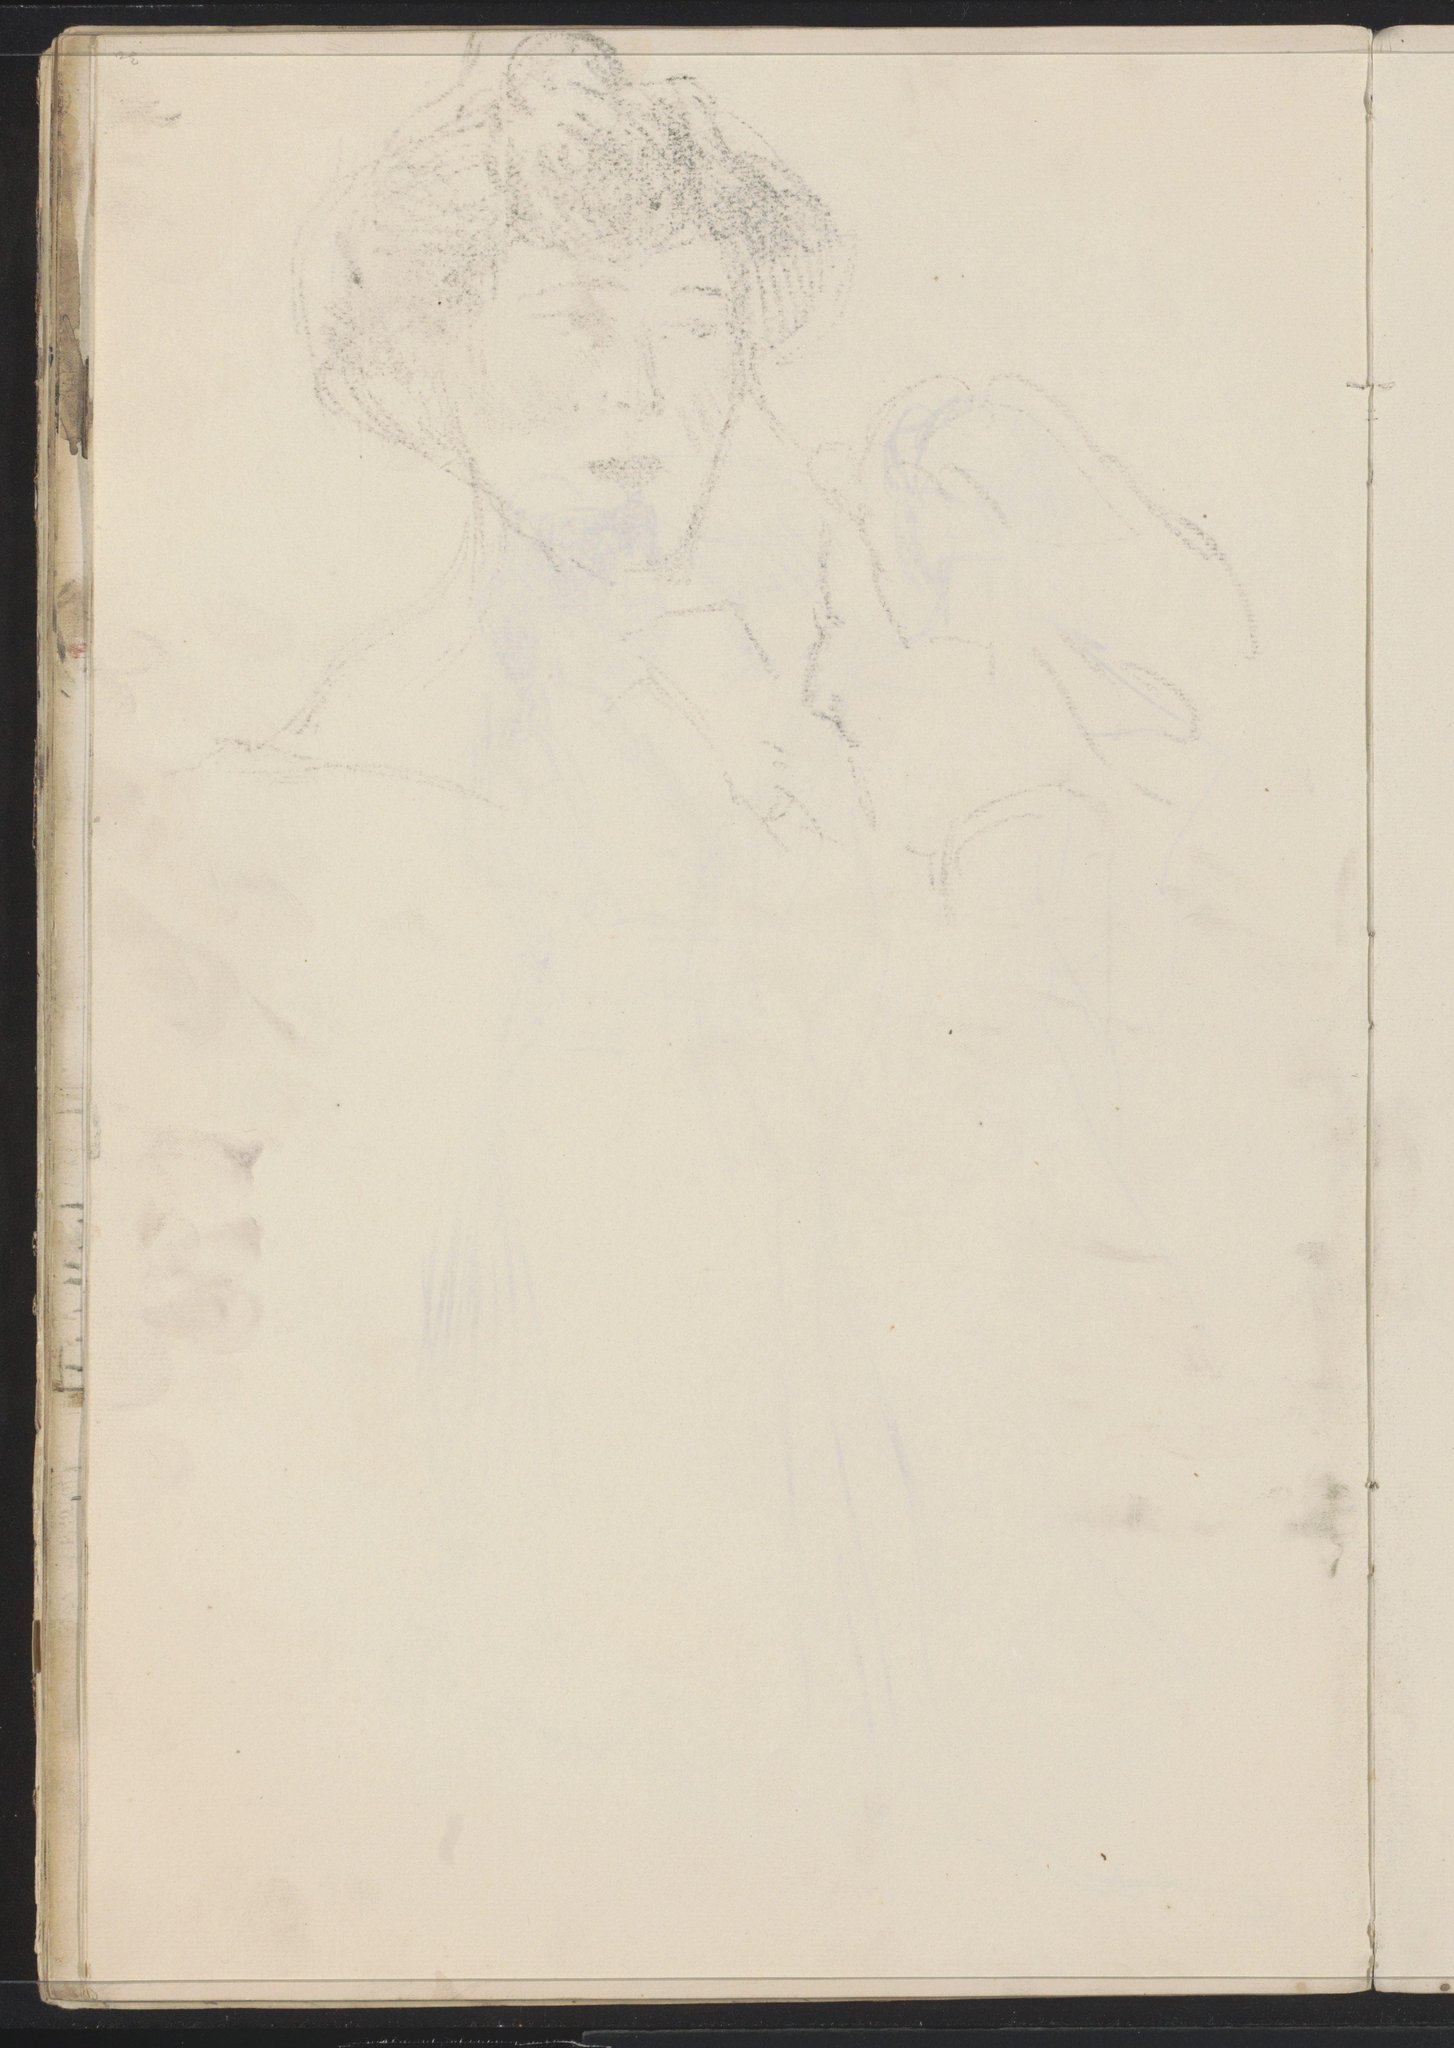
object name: sketchbook leaf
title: Abklatsch van de krijttekening op blad 22 recto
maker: isaac israels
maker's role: draughtsman, painter, print maker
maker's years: 1865-1934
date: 1875-1934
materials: paper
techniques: printmaking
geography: the hague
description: Blad 21 verso uit schetsboek LXIX met 25 bladen.